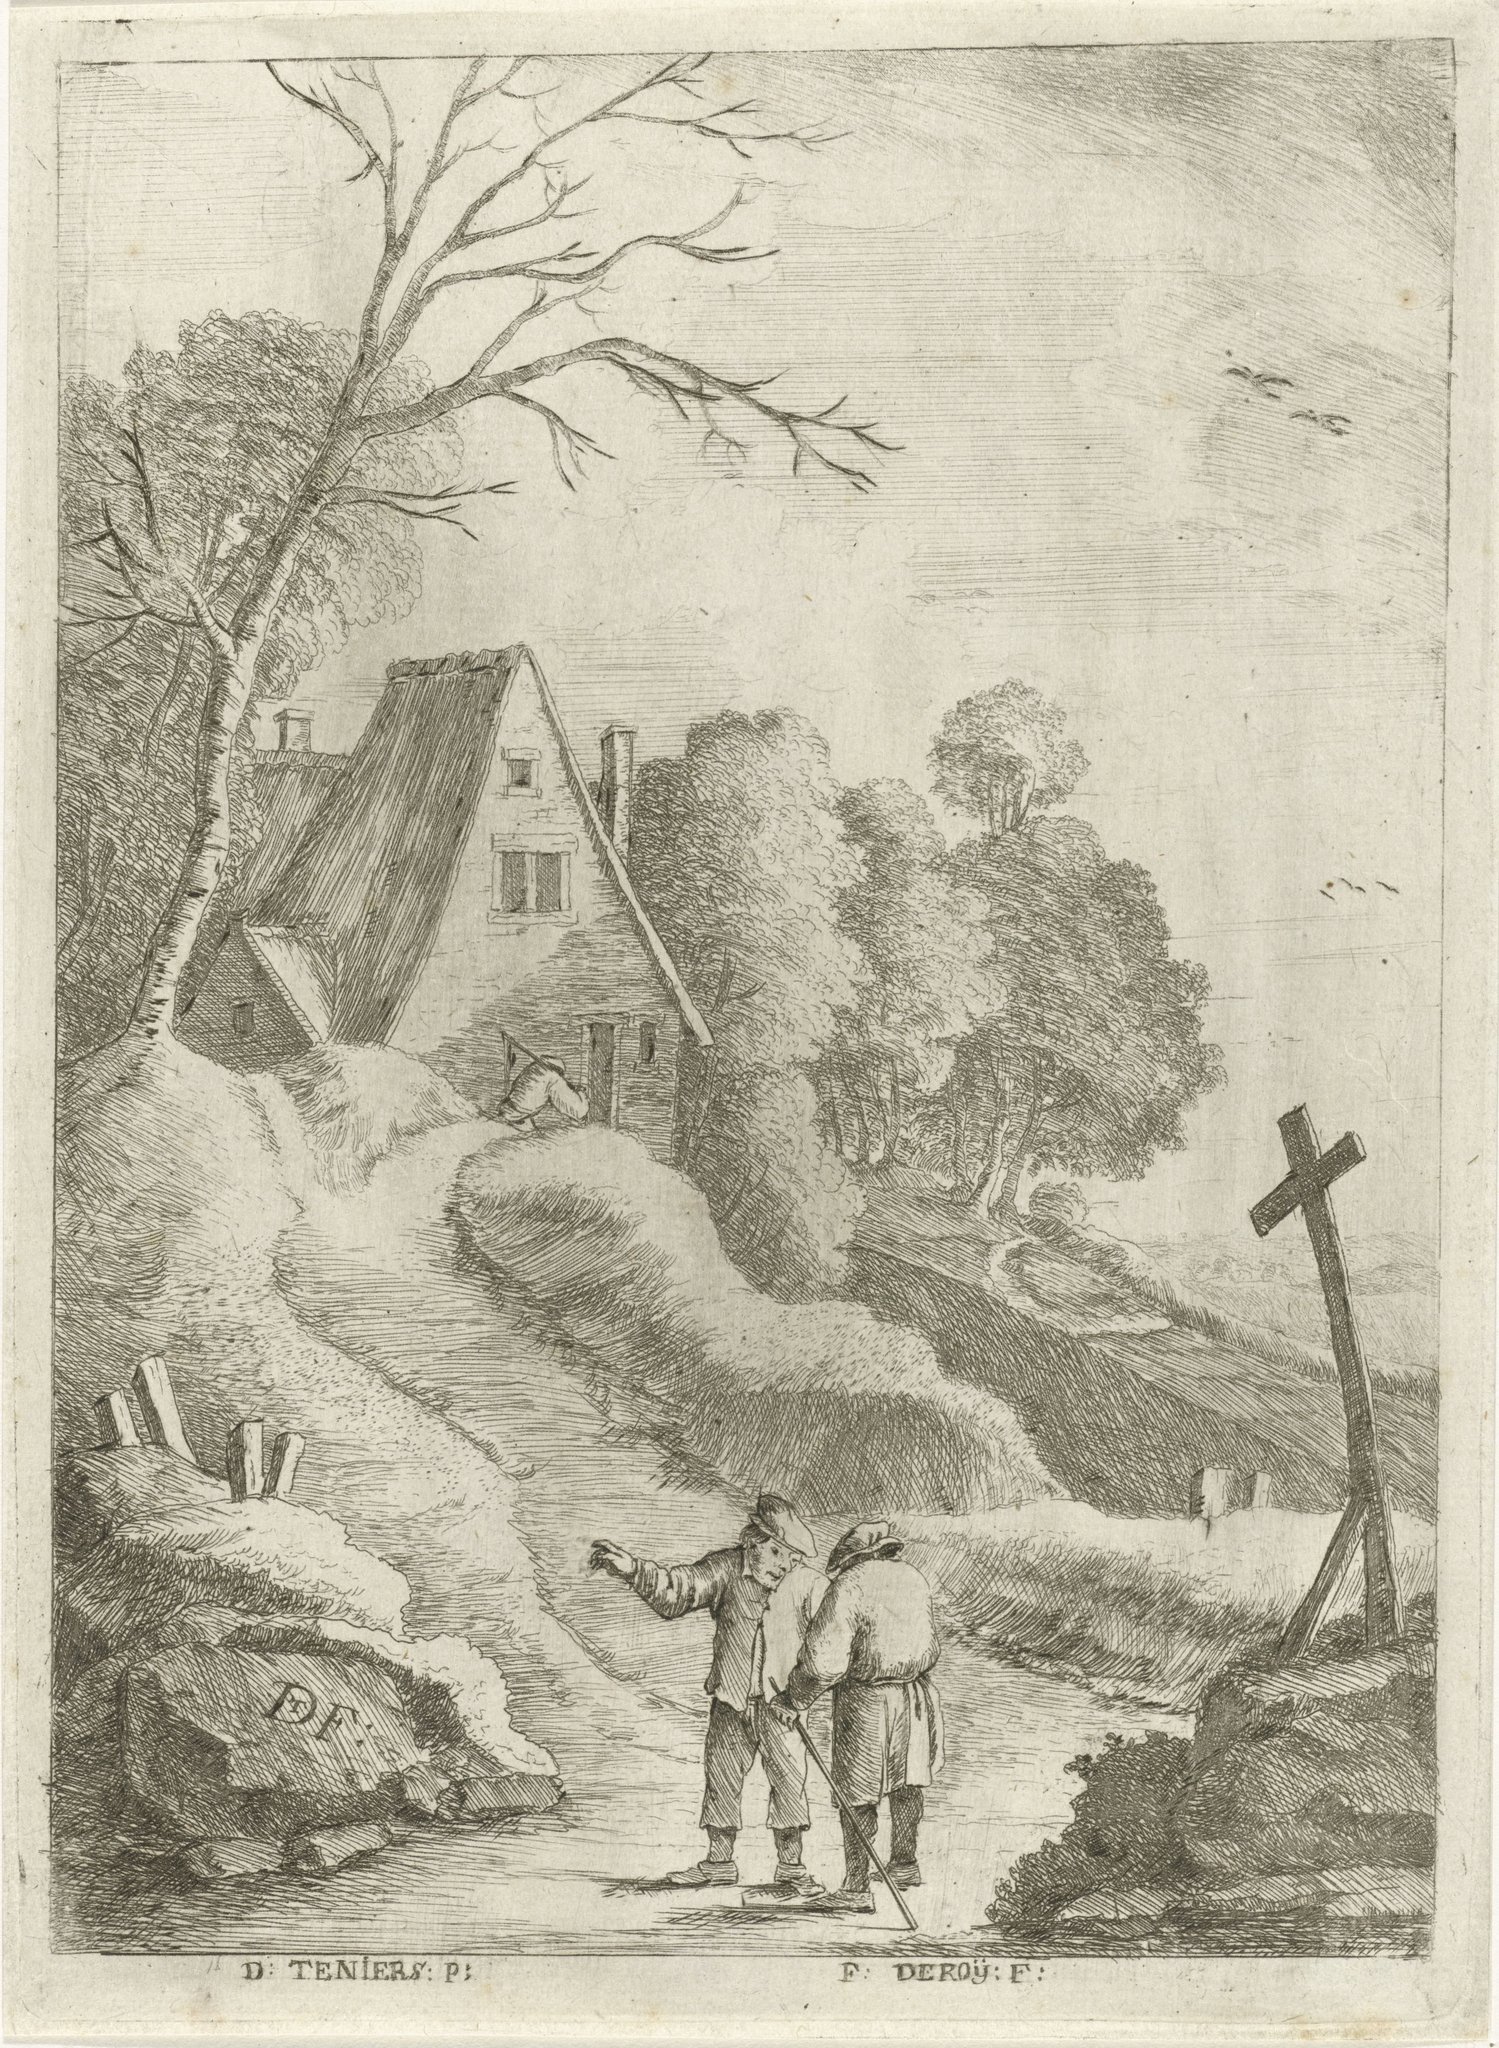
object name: print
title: Heuvelachtig landschap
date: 1758-1762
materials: paper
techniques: etching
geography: southern netherlands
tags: low hill country, other memorial structures, conversation, dialogue; conversation piece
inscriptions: collector's mark: Lugt 2228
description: Heuvelachtig landschap met op de voorgrond een kruis en twee mannen in conversatie. Op de achtergrond een huis tussen het geboomte.